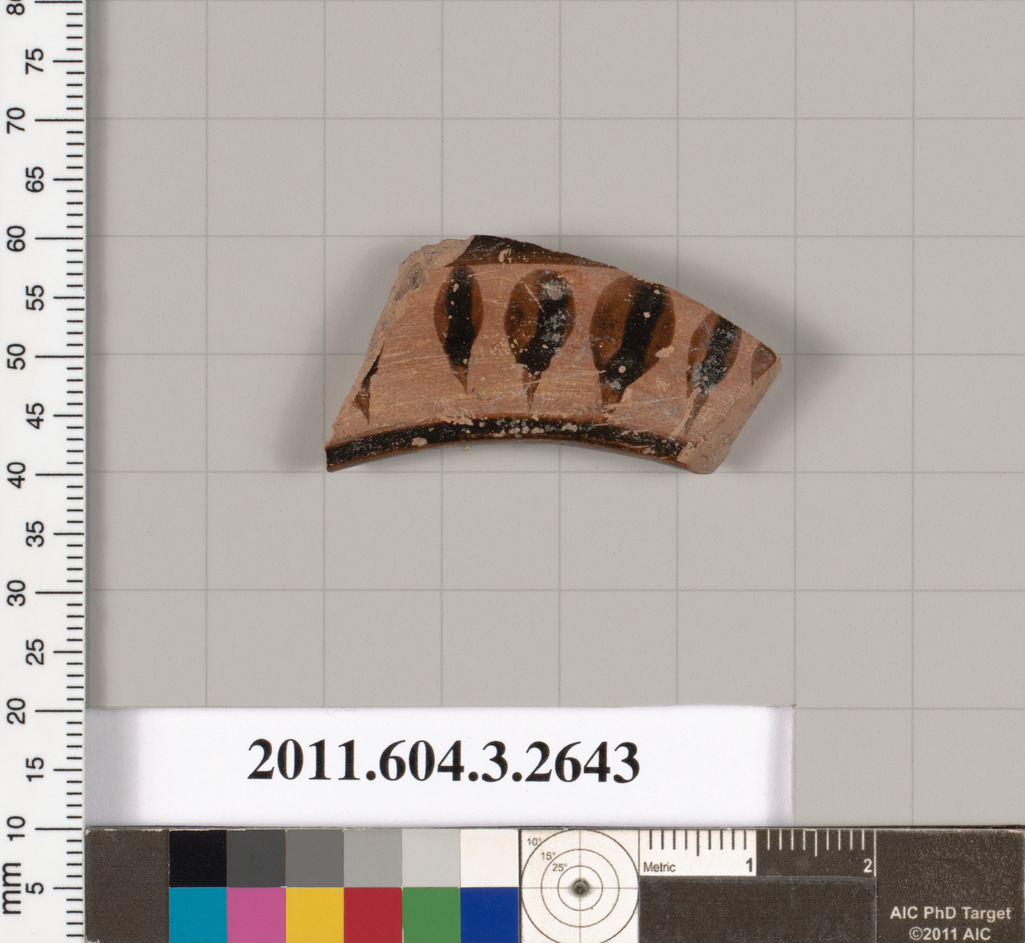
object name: undetermined shape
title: Terracotta fragment of an undetermined shape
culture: greek, attic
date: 600-501 BCE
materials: terracotta